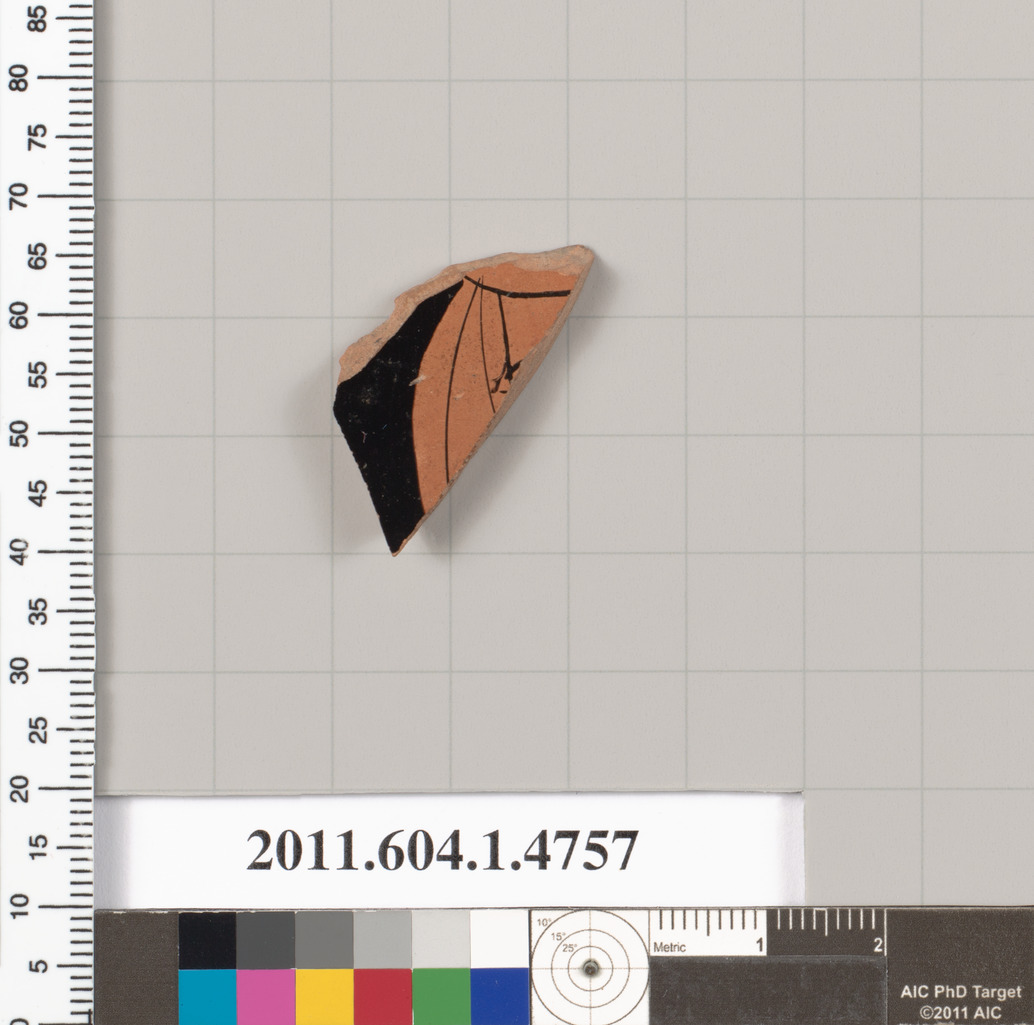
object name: kylix fragment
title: Terracotta fragment of a kylix (drinking cup)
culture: greek, attic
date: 475-451 BCE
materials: terracotta